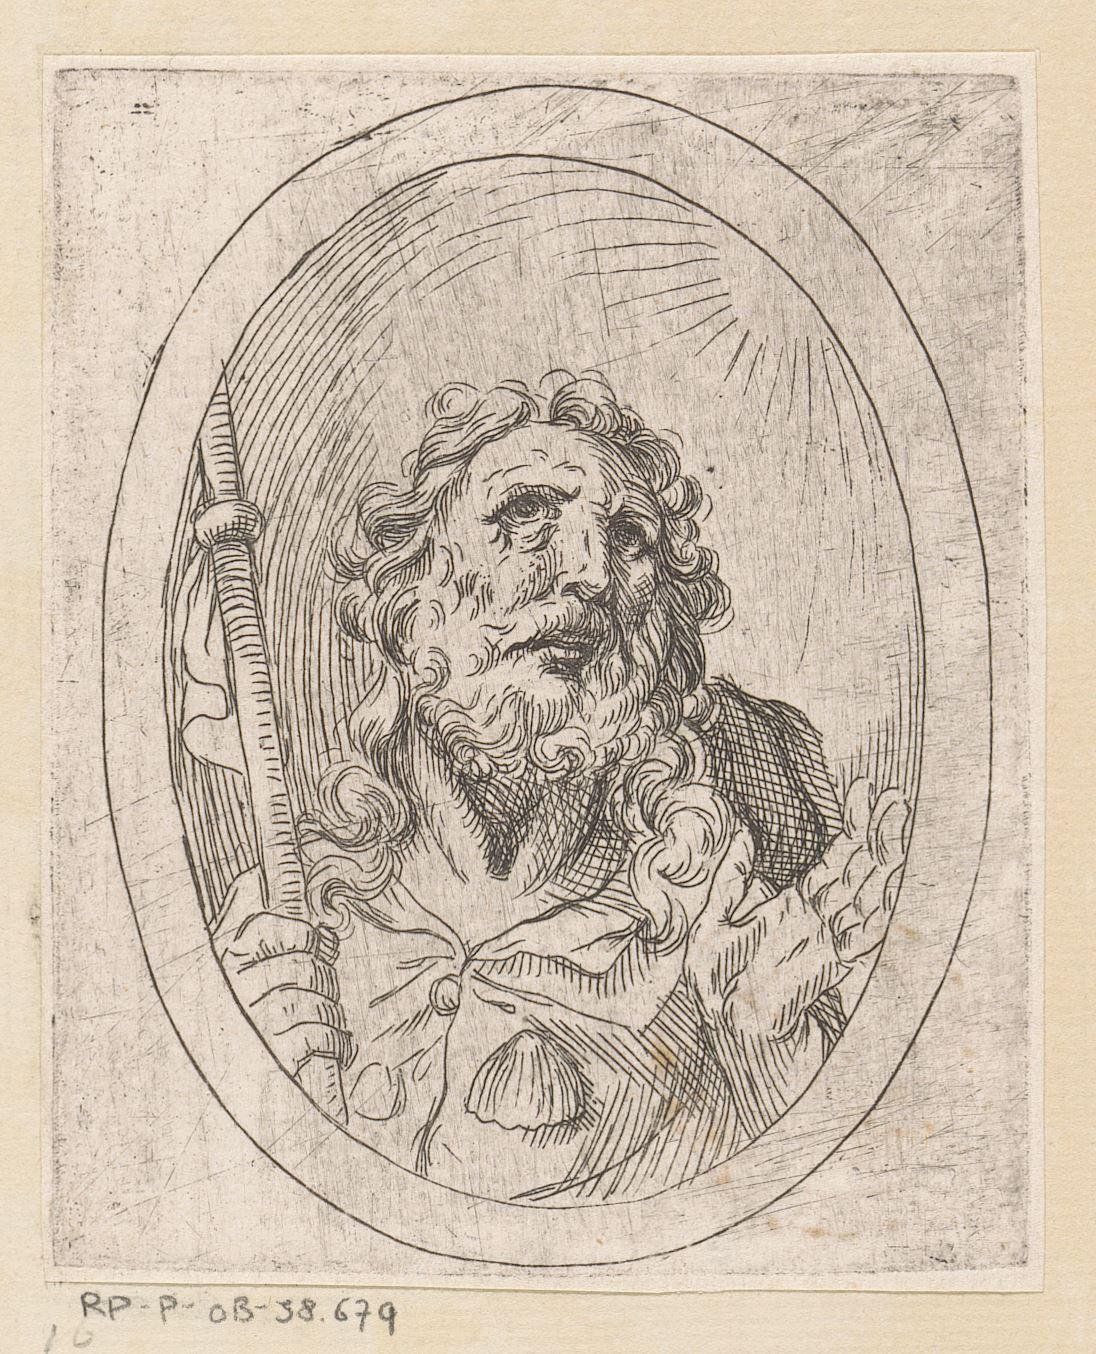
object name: print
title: Heilige Jakobus de Meerdere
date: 1595-1692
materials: paper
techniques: etching, intaglio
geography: italy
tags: life and acts of james the great (the elder)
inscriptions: collector's mark: Lugt 240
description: Deze prent maakt deel uit van een serie van vijftien prenten met beeltenissen van Christus, Maria en apostelen, gevat in ovalen.